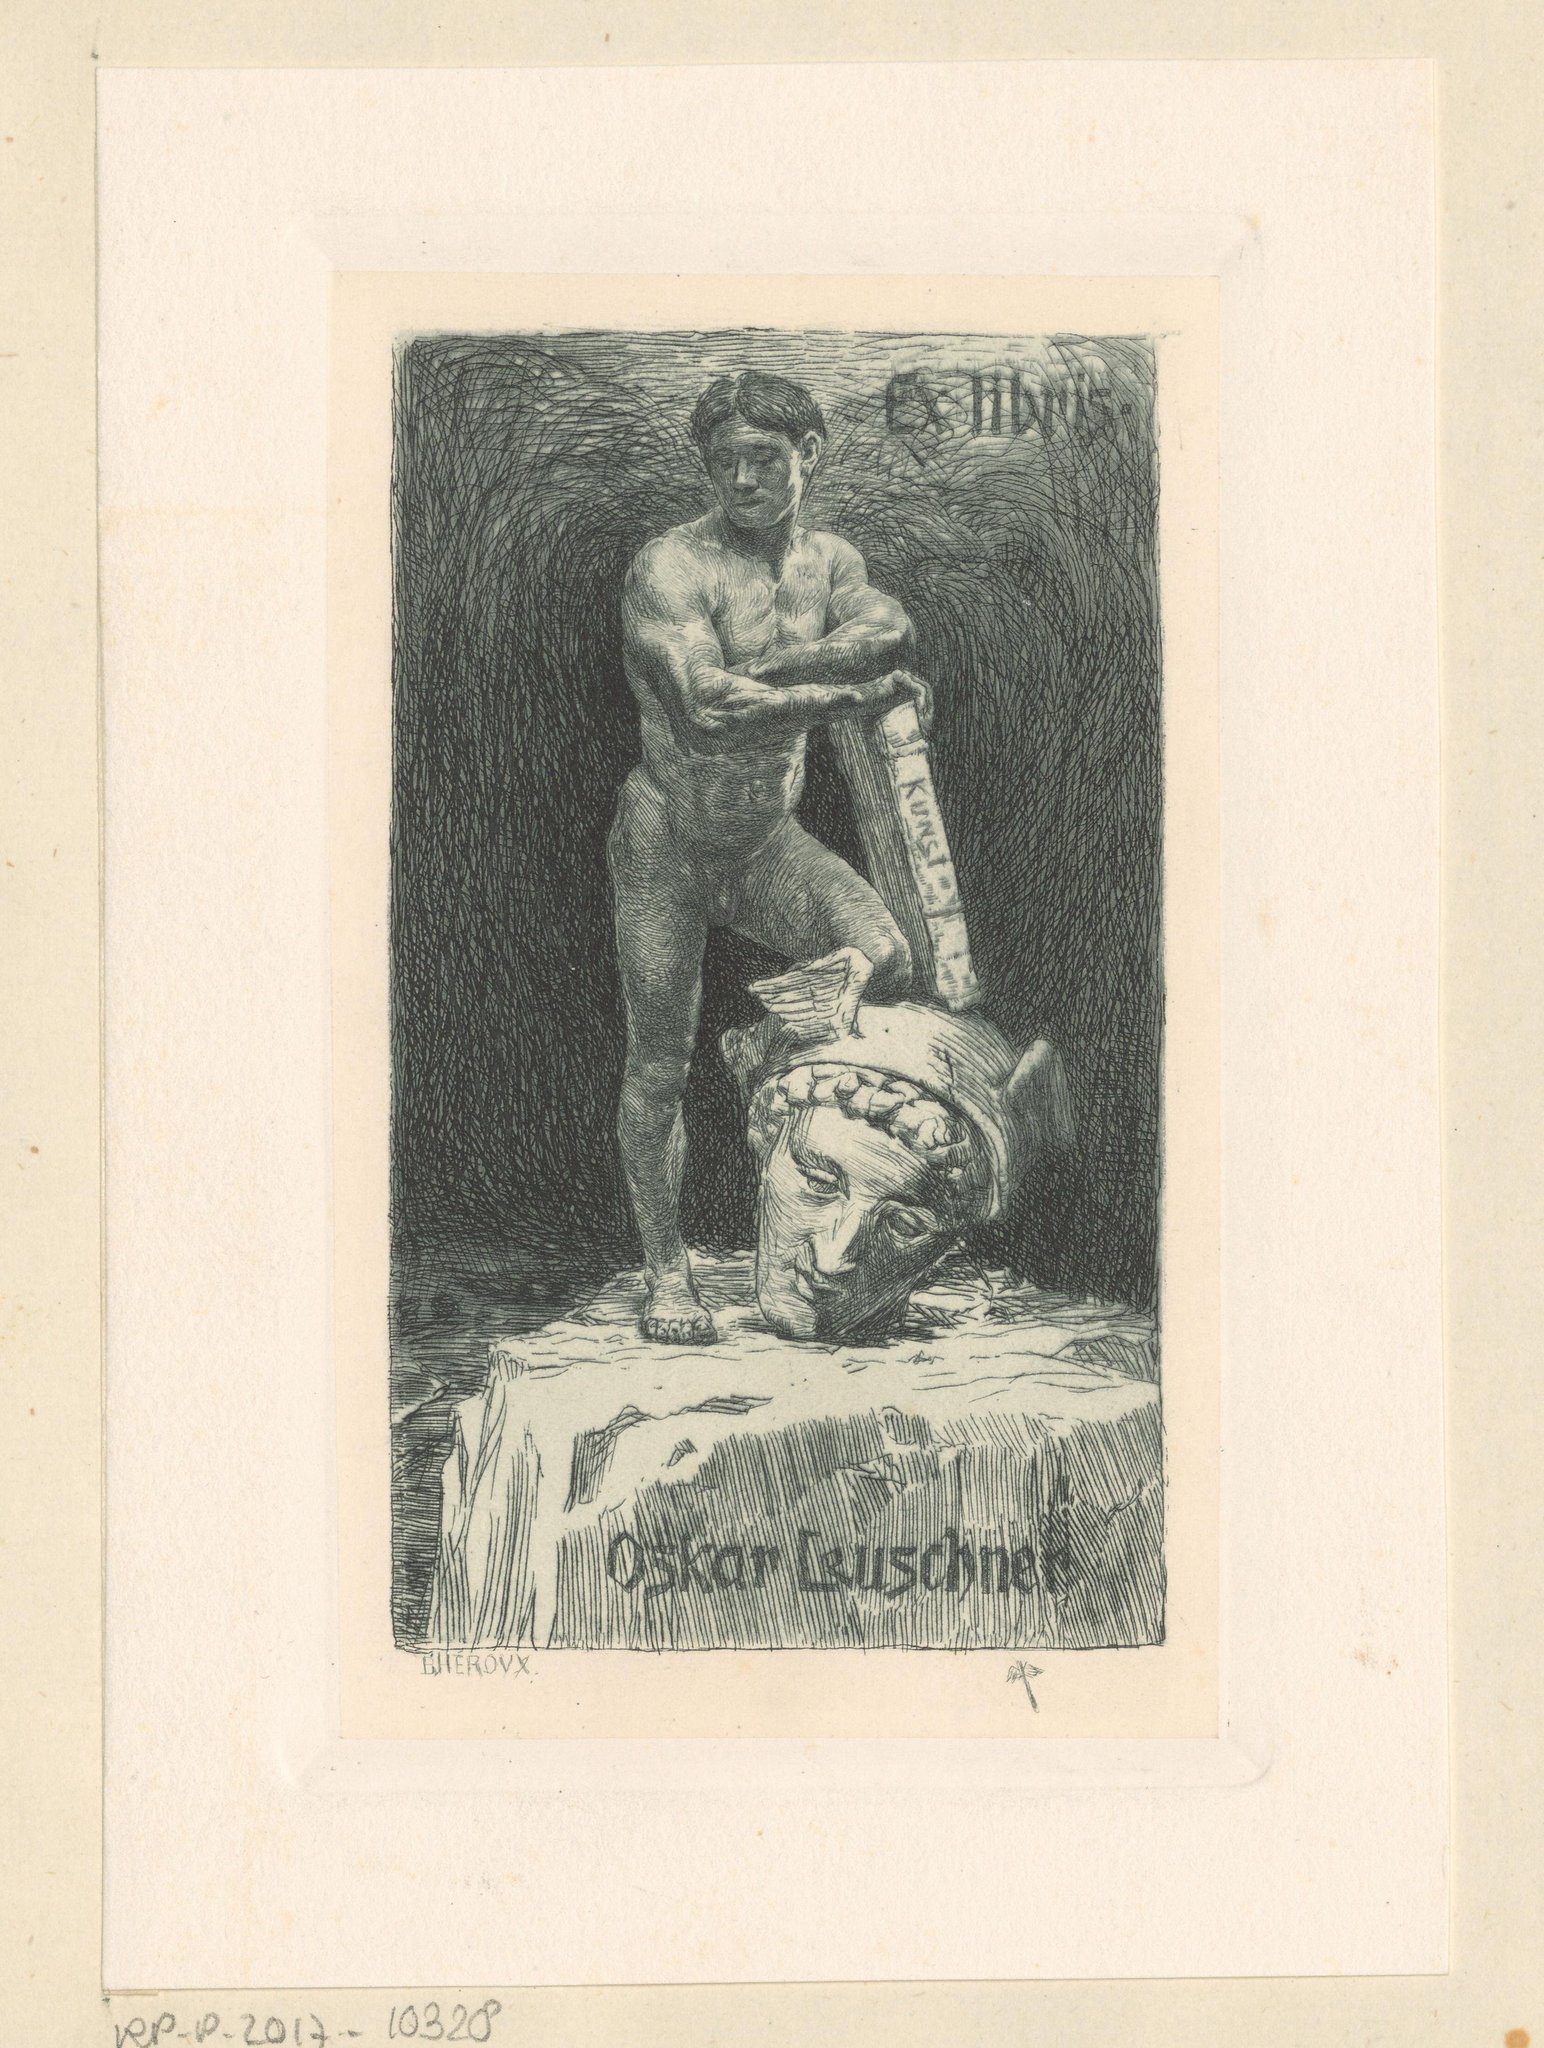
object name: bookplate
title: Ex libris van Oskar Leuschner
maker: bruno héroux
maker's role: painter, print maker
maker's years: 1868-1944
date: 1880-1935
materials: paper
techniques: etching, intaglio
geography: germany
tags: (story of) mercury (hermes), book, man (showing himself) undressed, quasi-nude